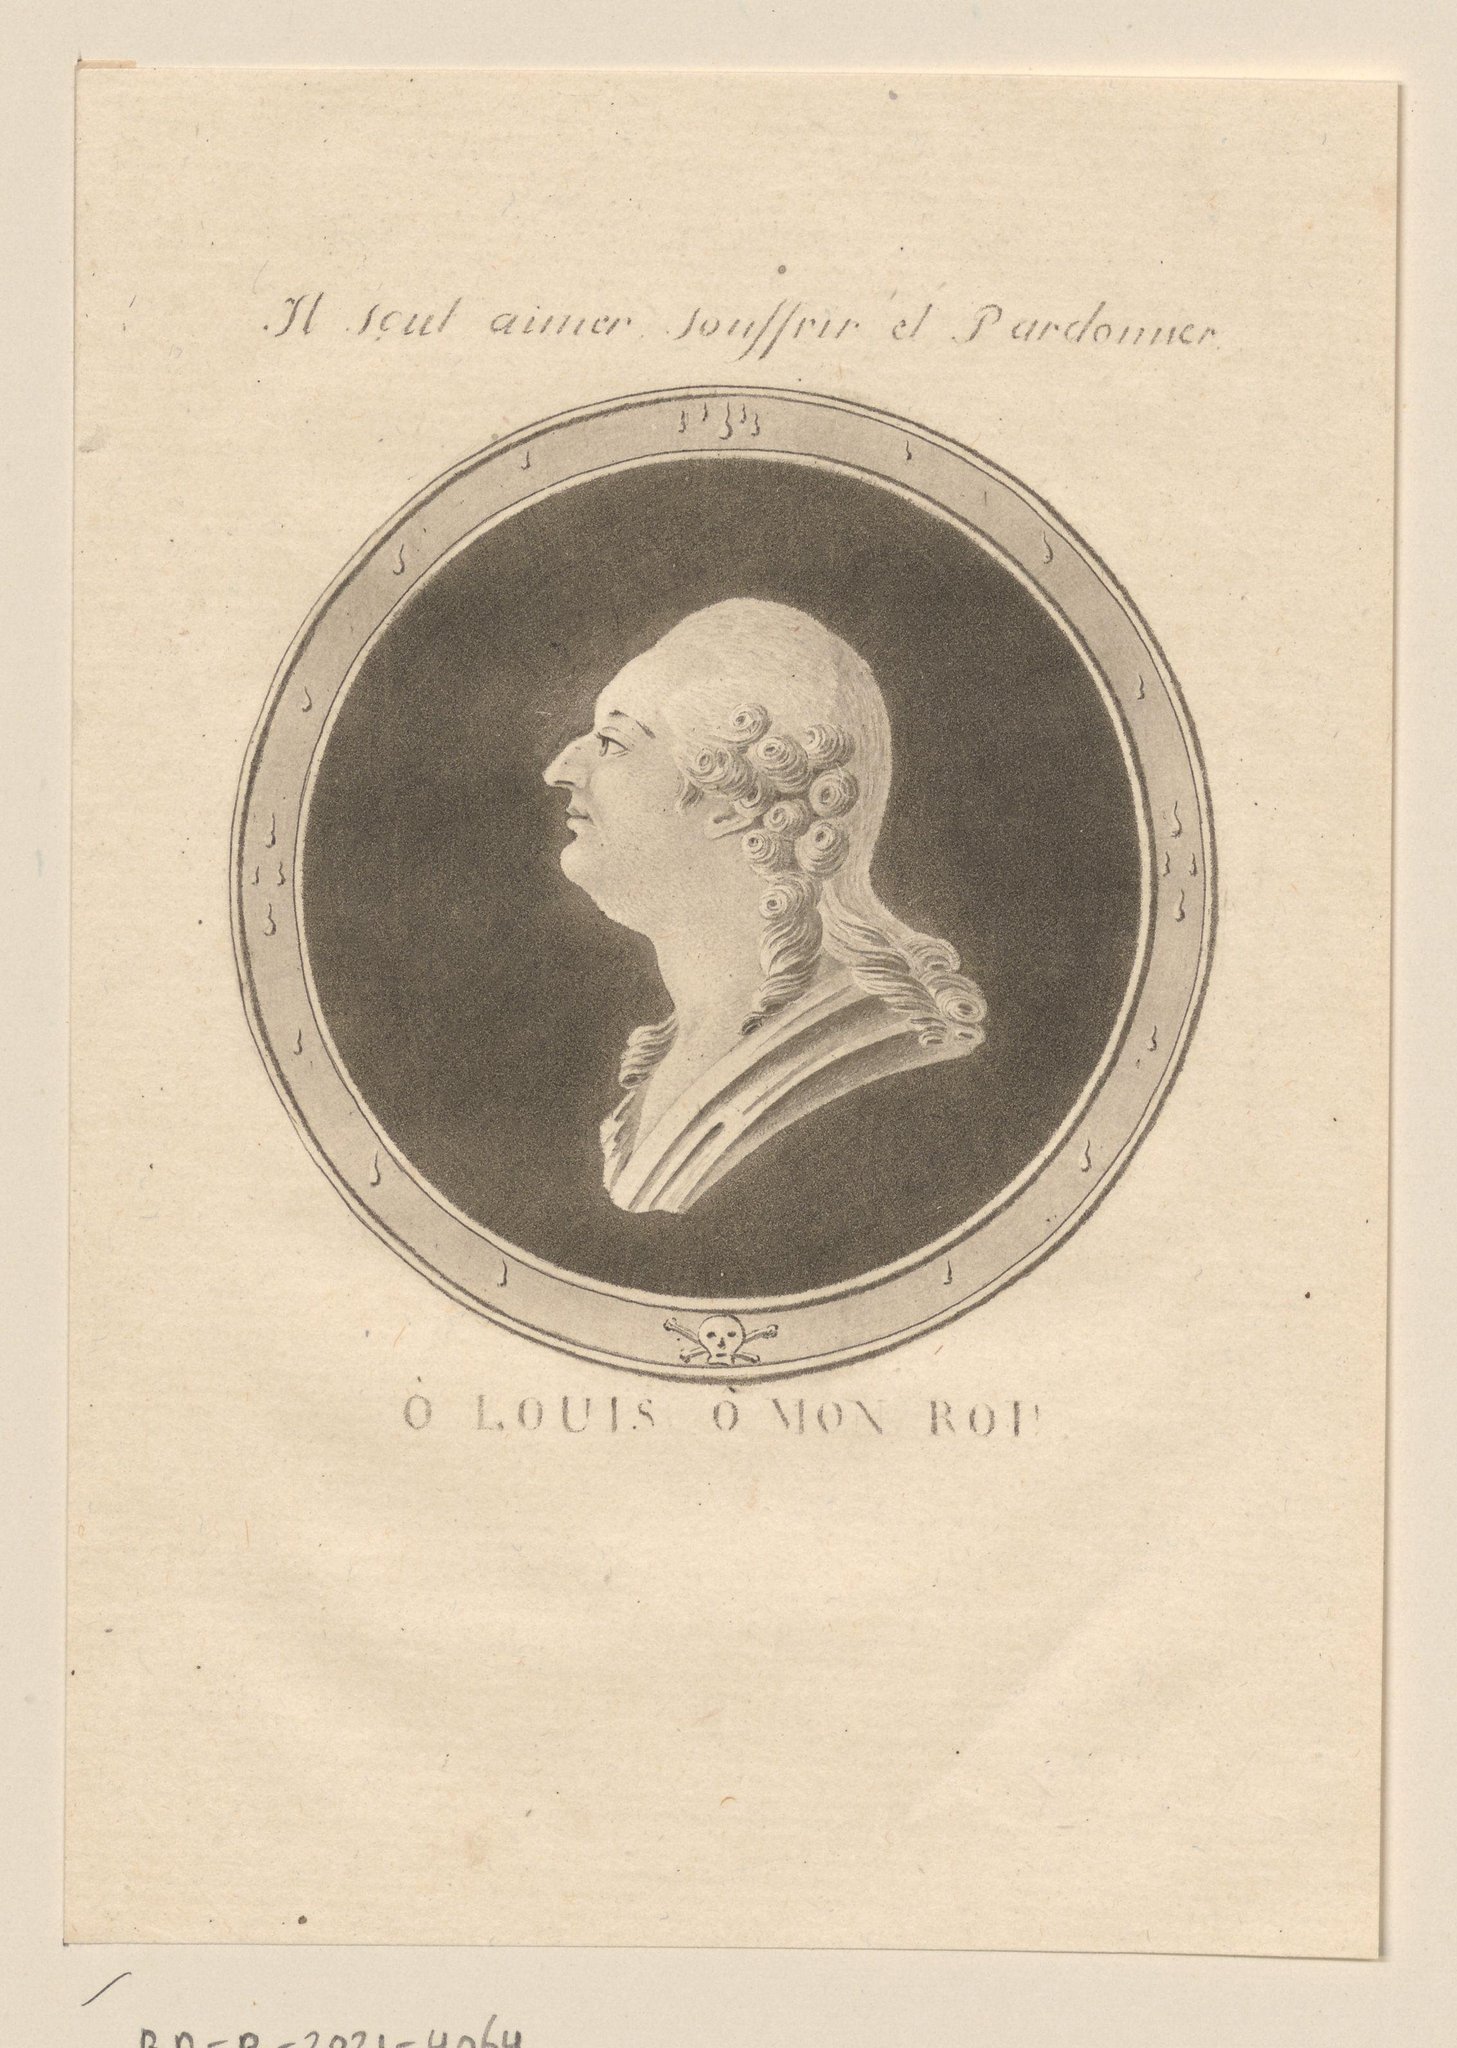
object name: print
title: Portret van Lodewijk XVI van Frankrijk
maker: Anonymous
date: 1793-1795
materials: paper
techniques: aquatint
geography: france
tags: paris, lodewijk xvi (koning van frankrijk), historical persons, king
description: Boven en onder het portret twee regels in het Frans: Il sut aimer souffrir et Pardonner/ ò Louis ò mon roi!.